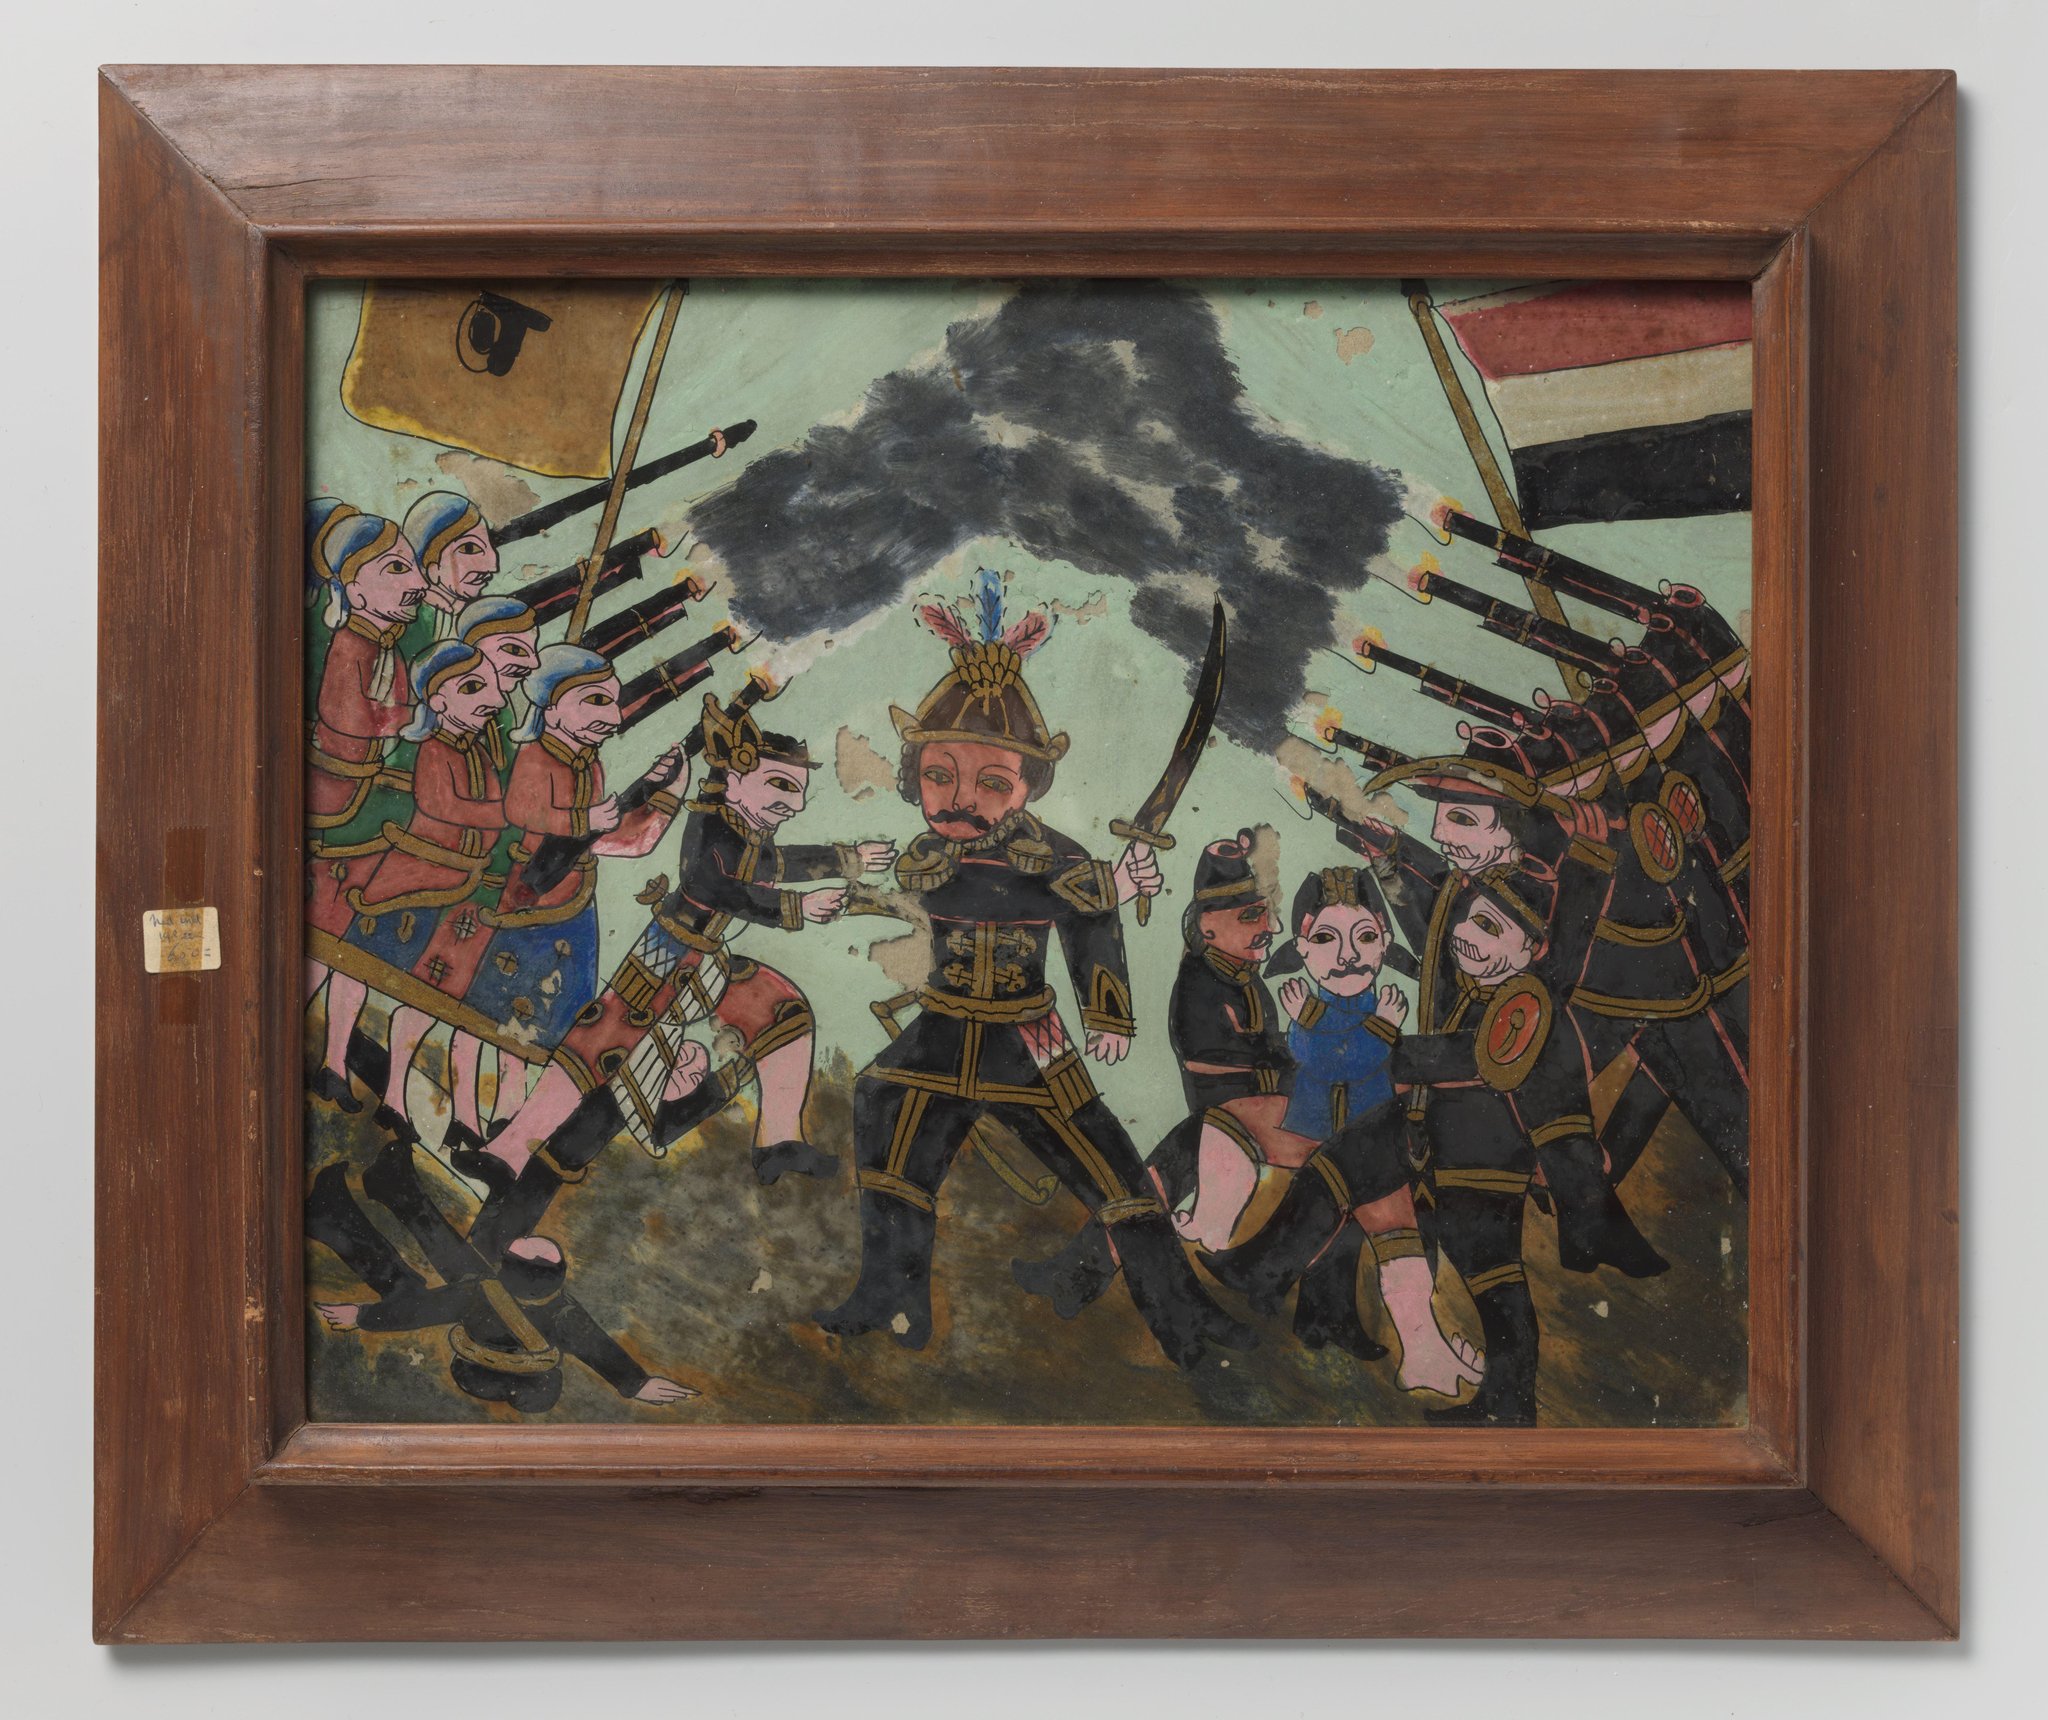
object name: painting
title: Gevecht tussen Nederlandse militairen en inlanders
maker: Anonymous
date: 1800-1900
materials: glass, oil, paper, wood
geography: dutch east indies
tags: dutch east indies, the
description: Schilderij achter glas in houten lijst. Links een groep Indonesische strijders met vlag, rechts een groep militairen met Nederlandse vlag. Beide groepen schieten met geweren. Midden op de voorgrond een Nederlandse officier in gevecht met de leider van de strijders. De Nederlandse soldaten hebben één man gevangen genomen. Op lichtgroene achtergrond.